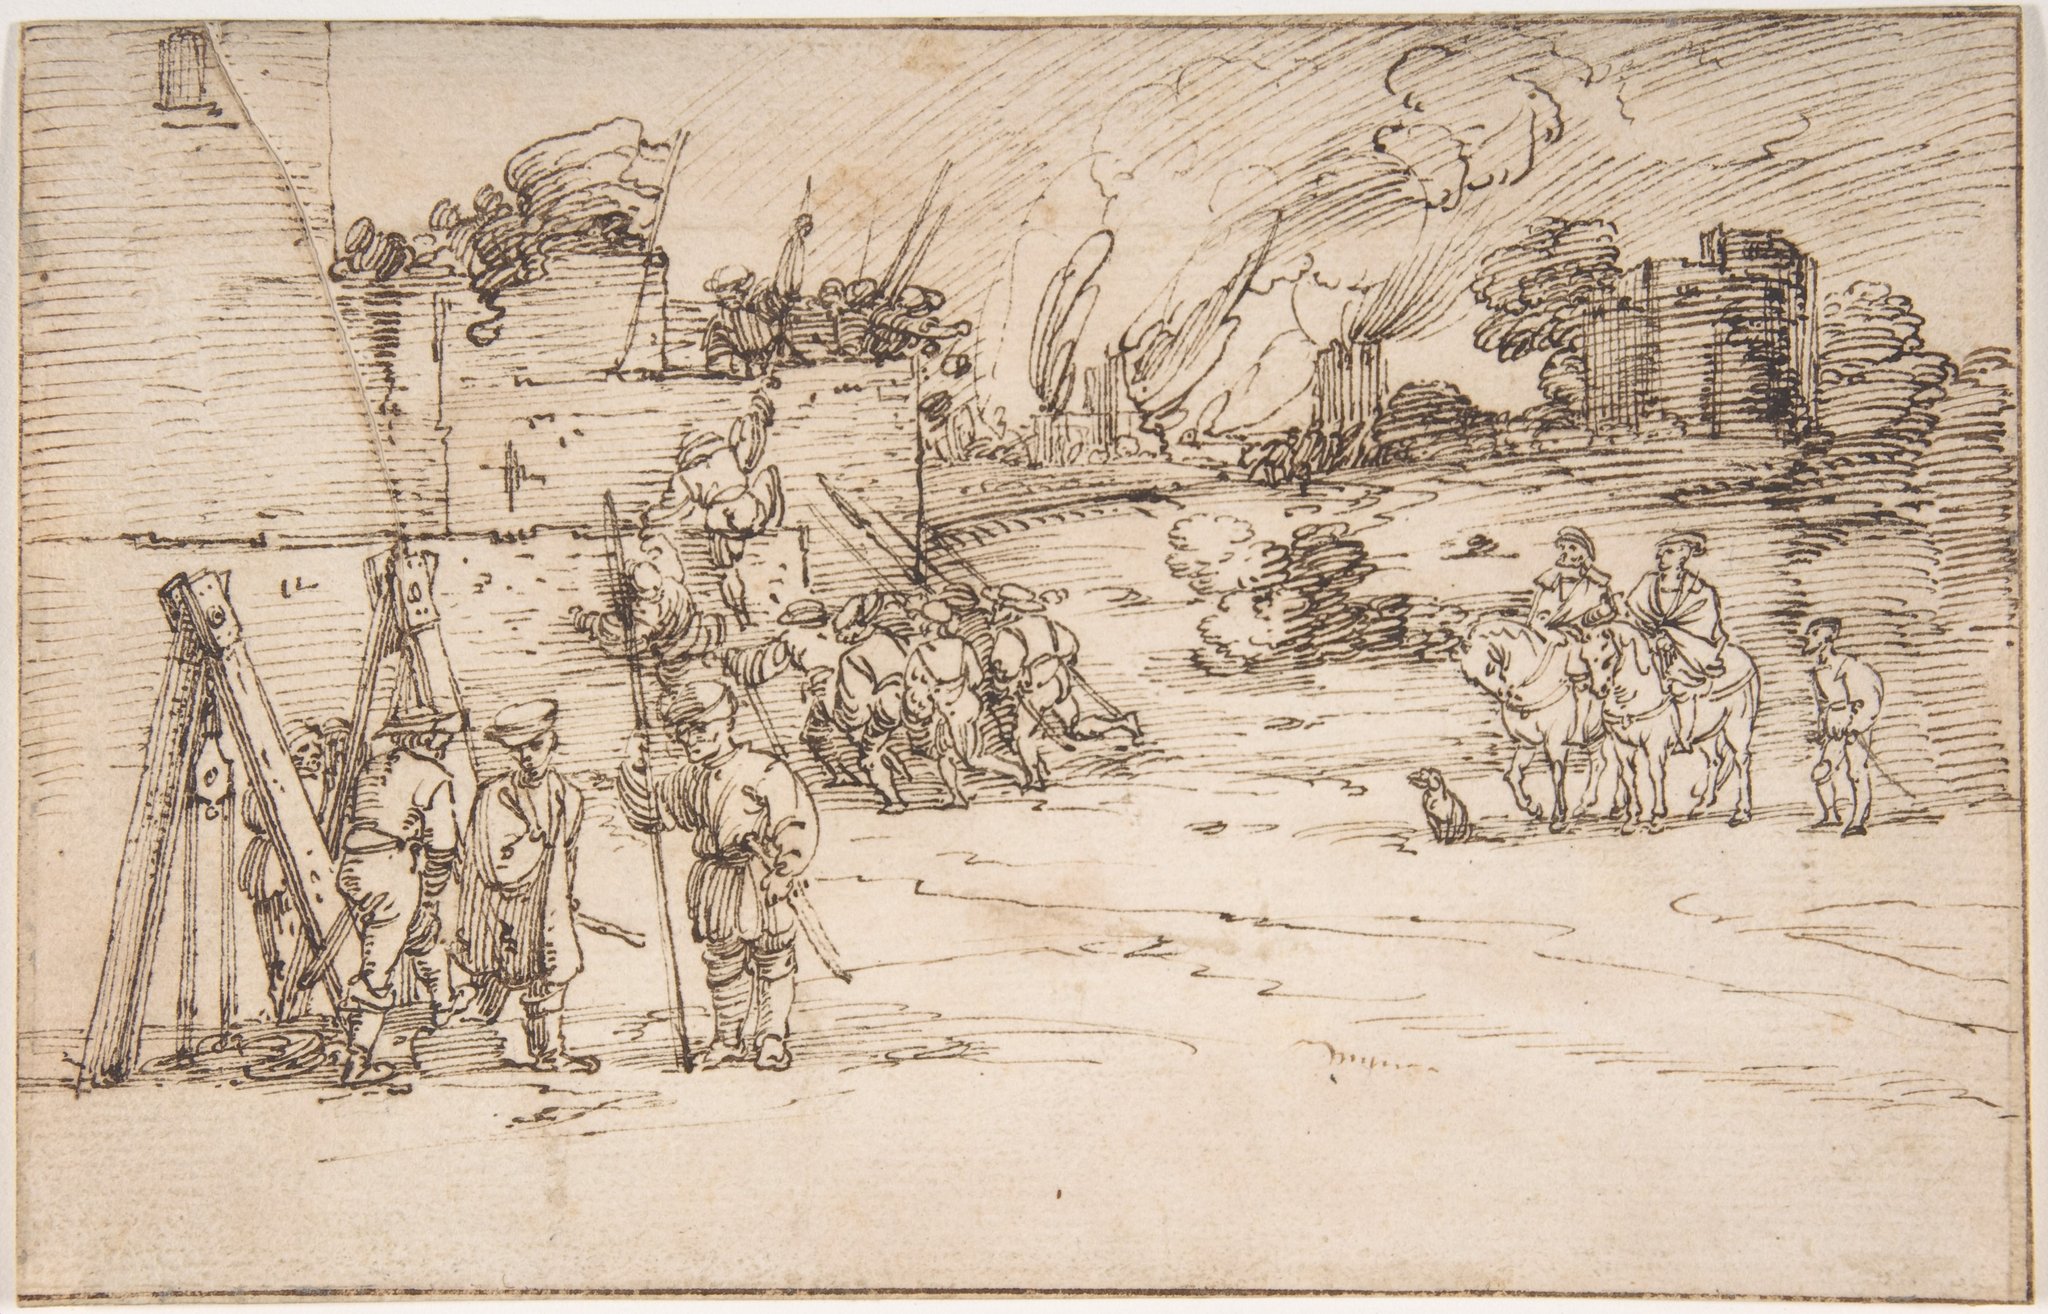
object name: drawing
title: Soldiers Besieging a Castle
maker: anonymous, swiss, 16th century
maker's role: artist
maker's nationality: swiss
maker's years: 1500-1600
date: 1530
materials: ink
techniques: pen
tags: castles,soldiers,horses